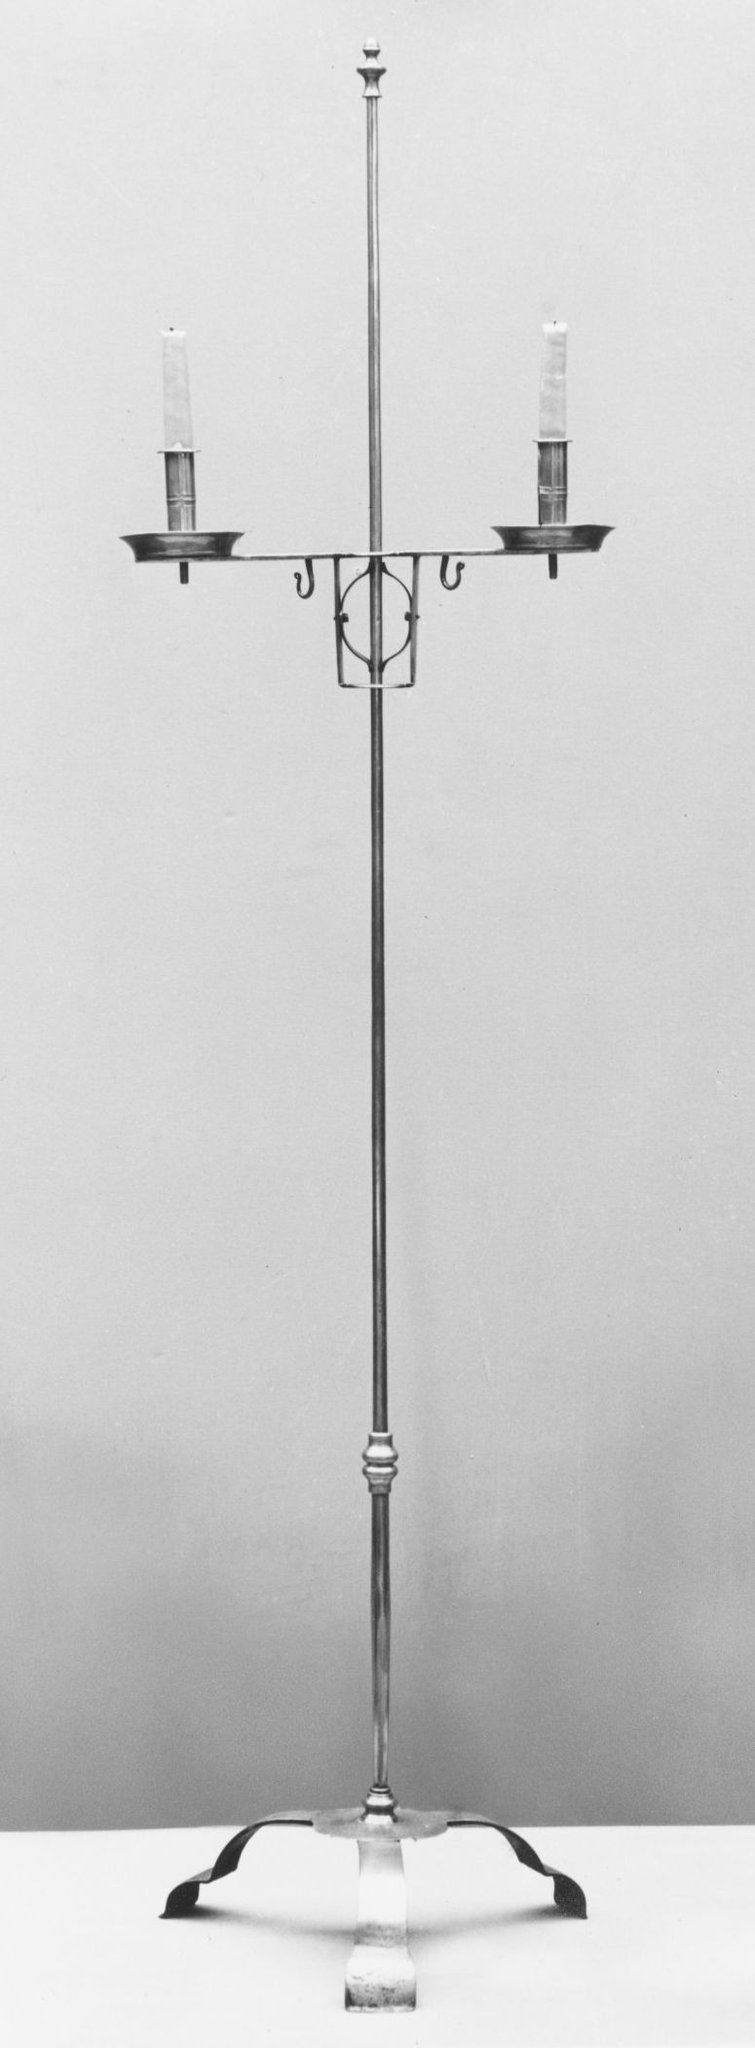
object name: candlestick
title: Standing candlestick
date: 1730-1750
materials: brass, iron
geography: united states